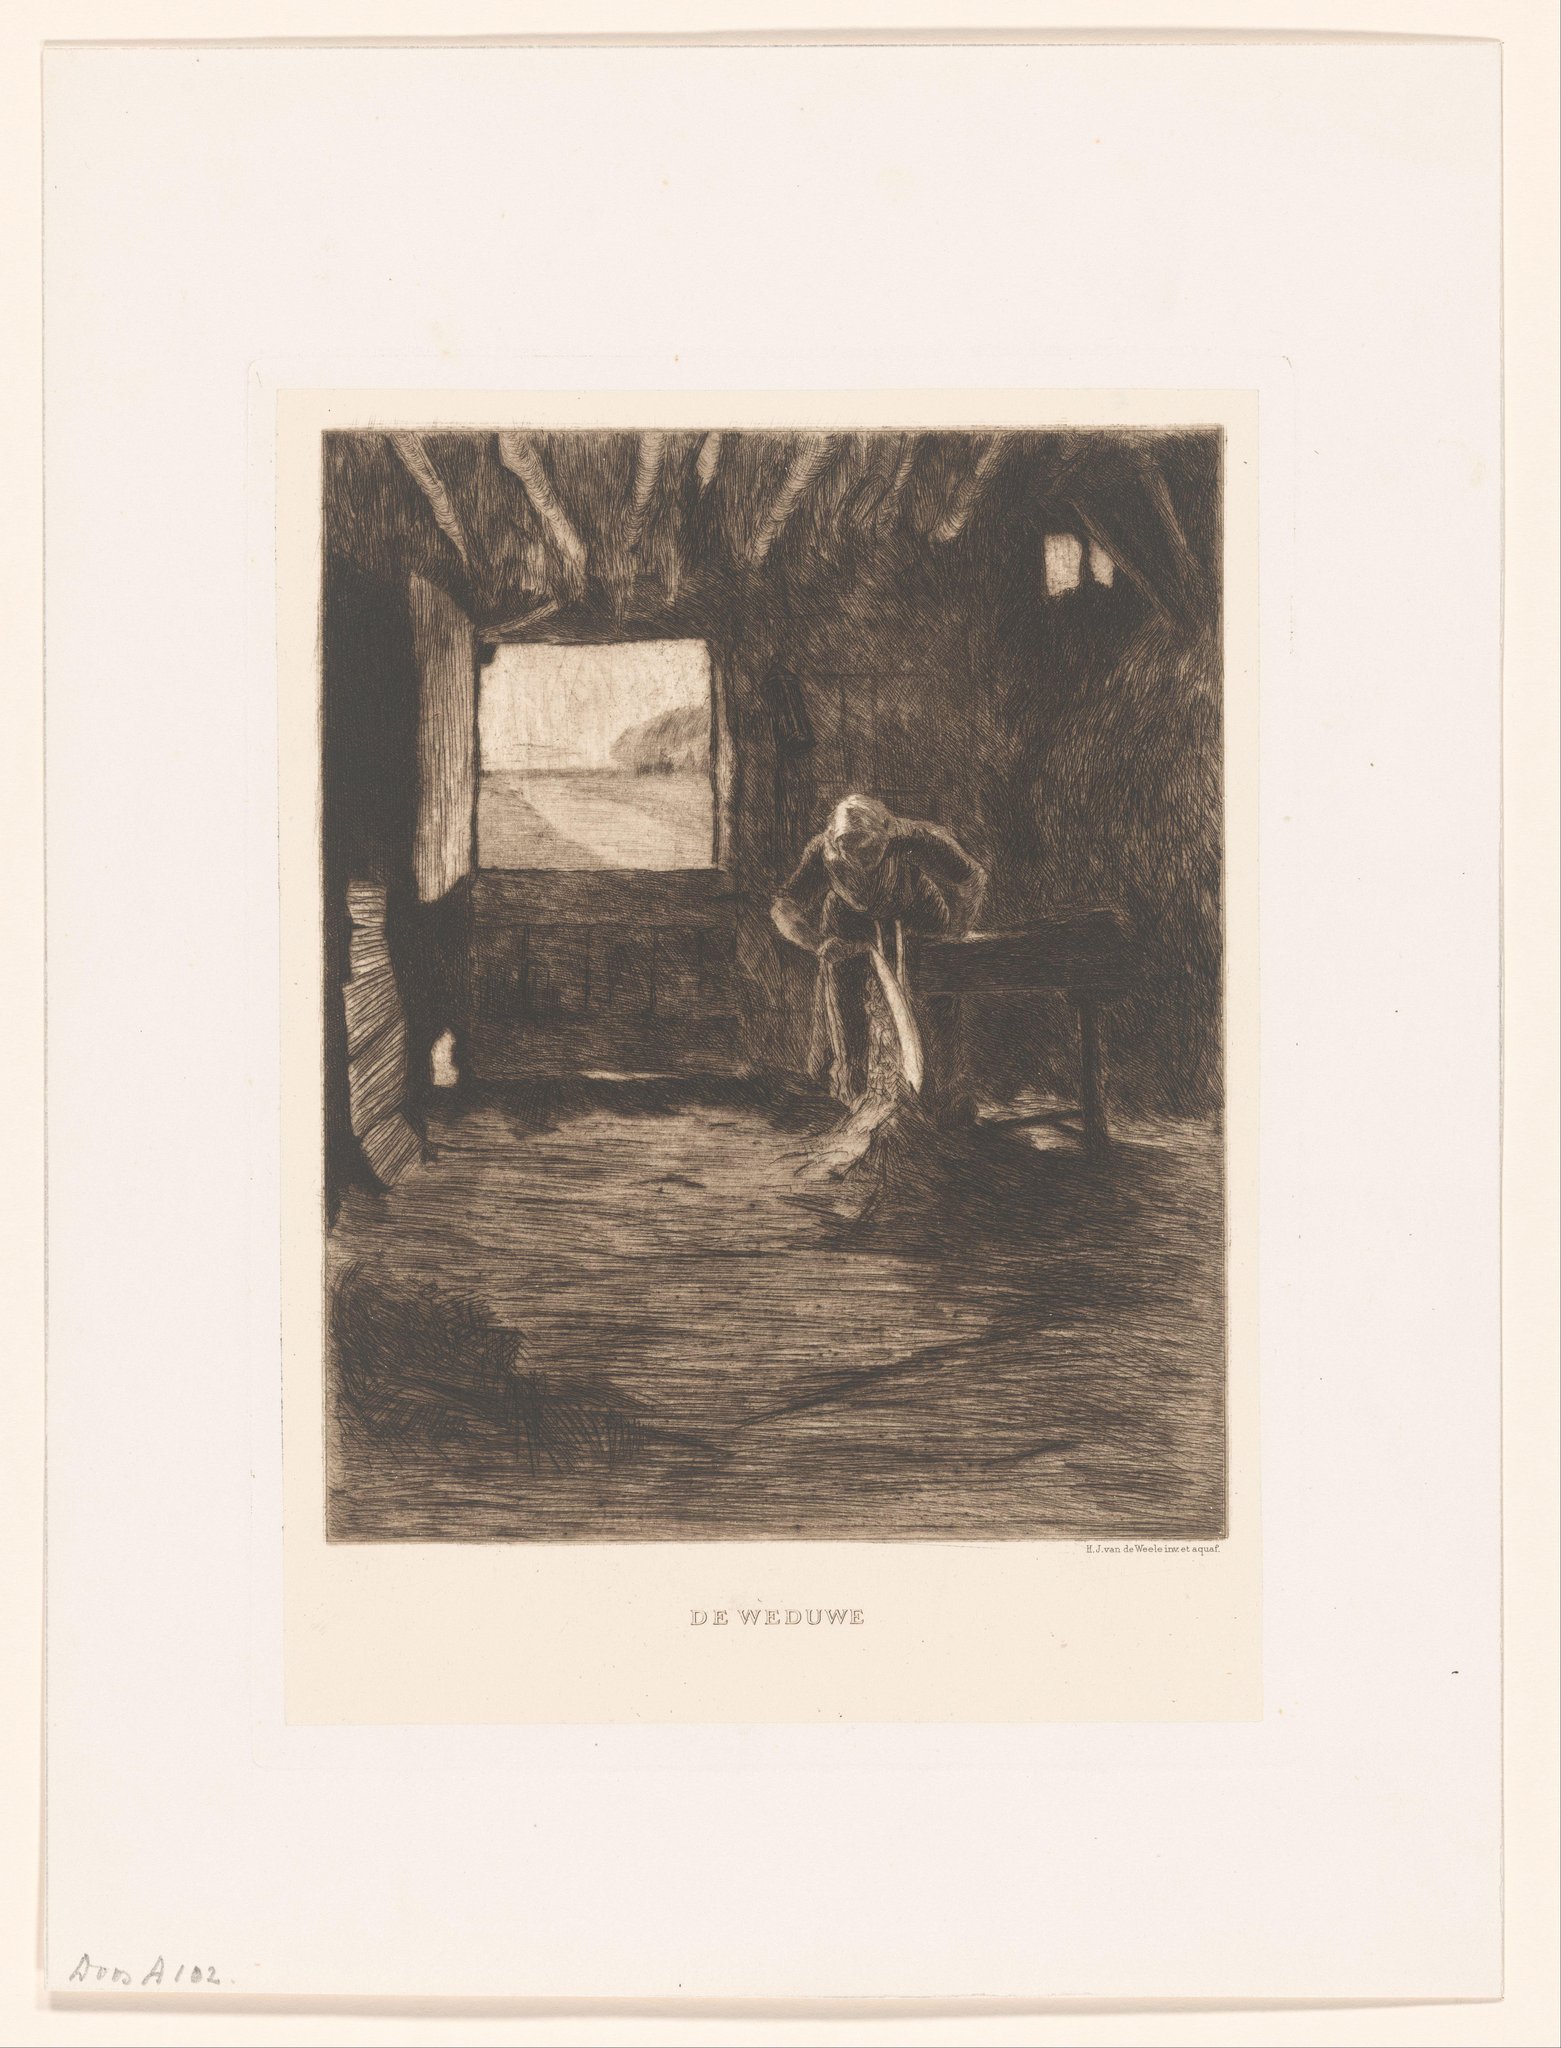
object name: print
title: Vrouw in een schuur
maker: herman johannes van der weele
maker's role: print maker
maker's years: 1852-1930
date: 1852-1930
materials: paper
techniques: drypoint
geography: netherlands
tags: barn, old woman, widow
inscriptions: collector's mark: Lugt 2228, collector's mark: Lugt 2760